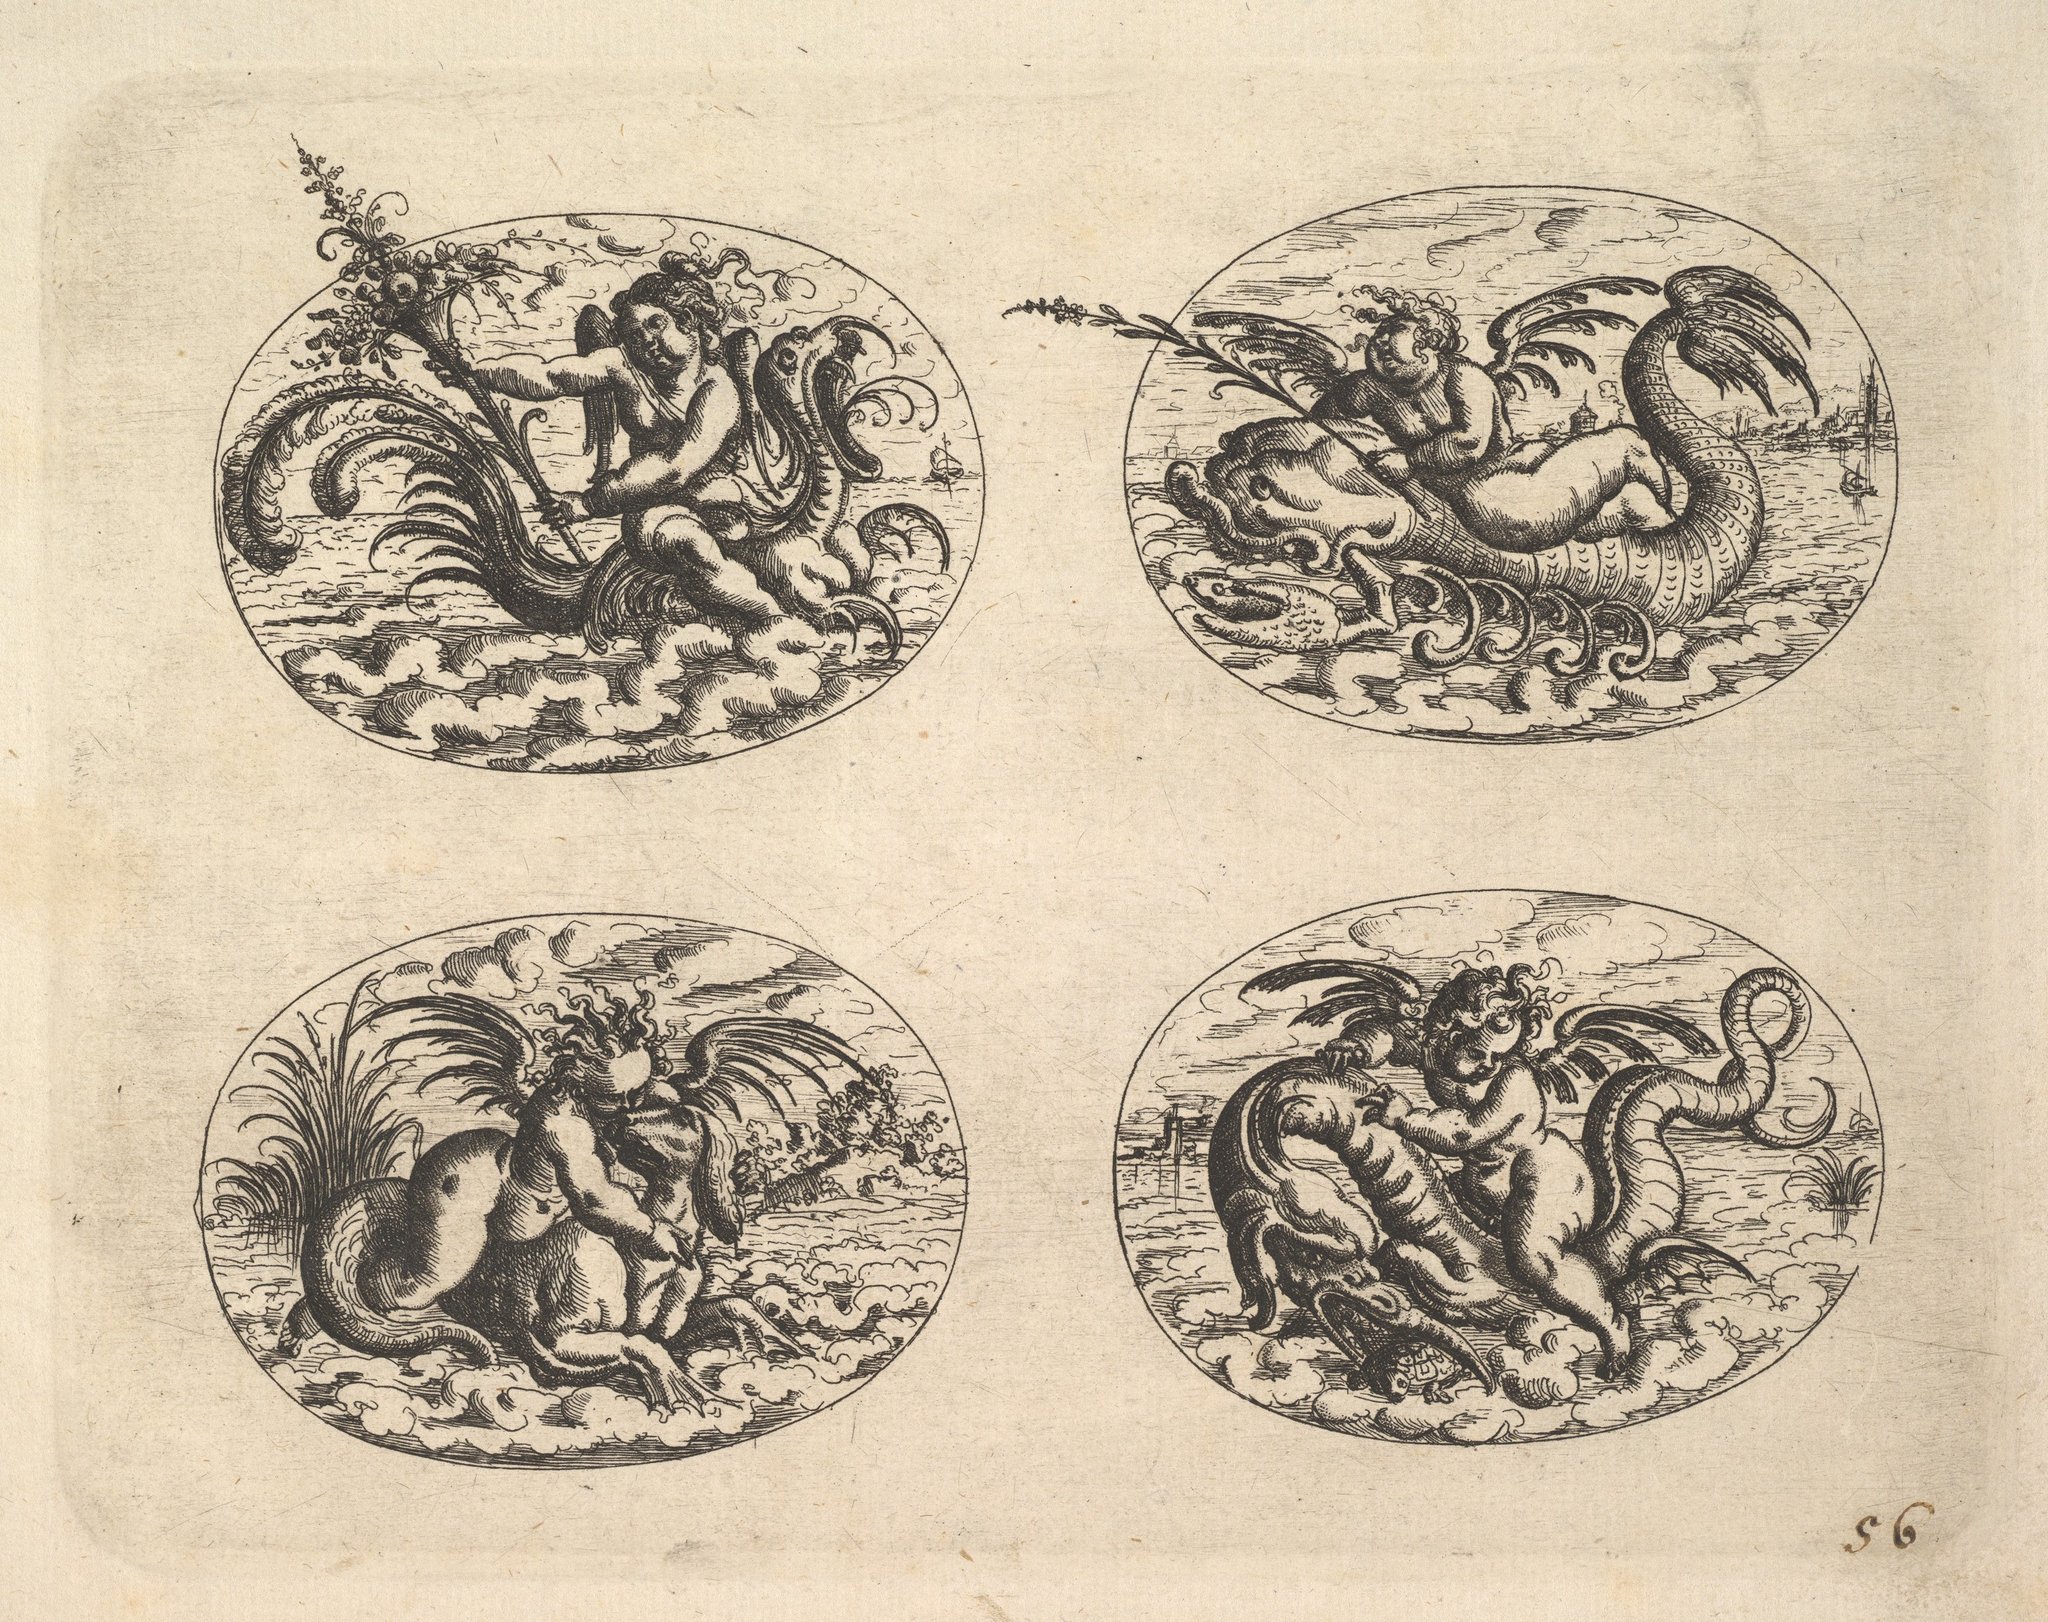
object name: print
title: Four Ovals with Genii, from "Neue Grotessken Buch"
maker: christoph jamnitzer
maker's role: artist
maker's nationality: german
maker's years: 1563-1618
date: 1610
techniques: etching